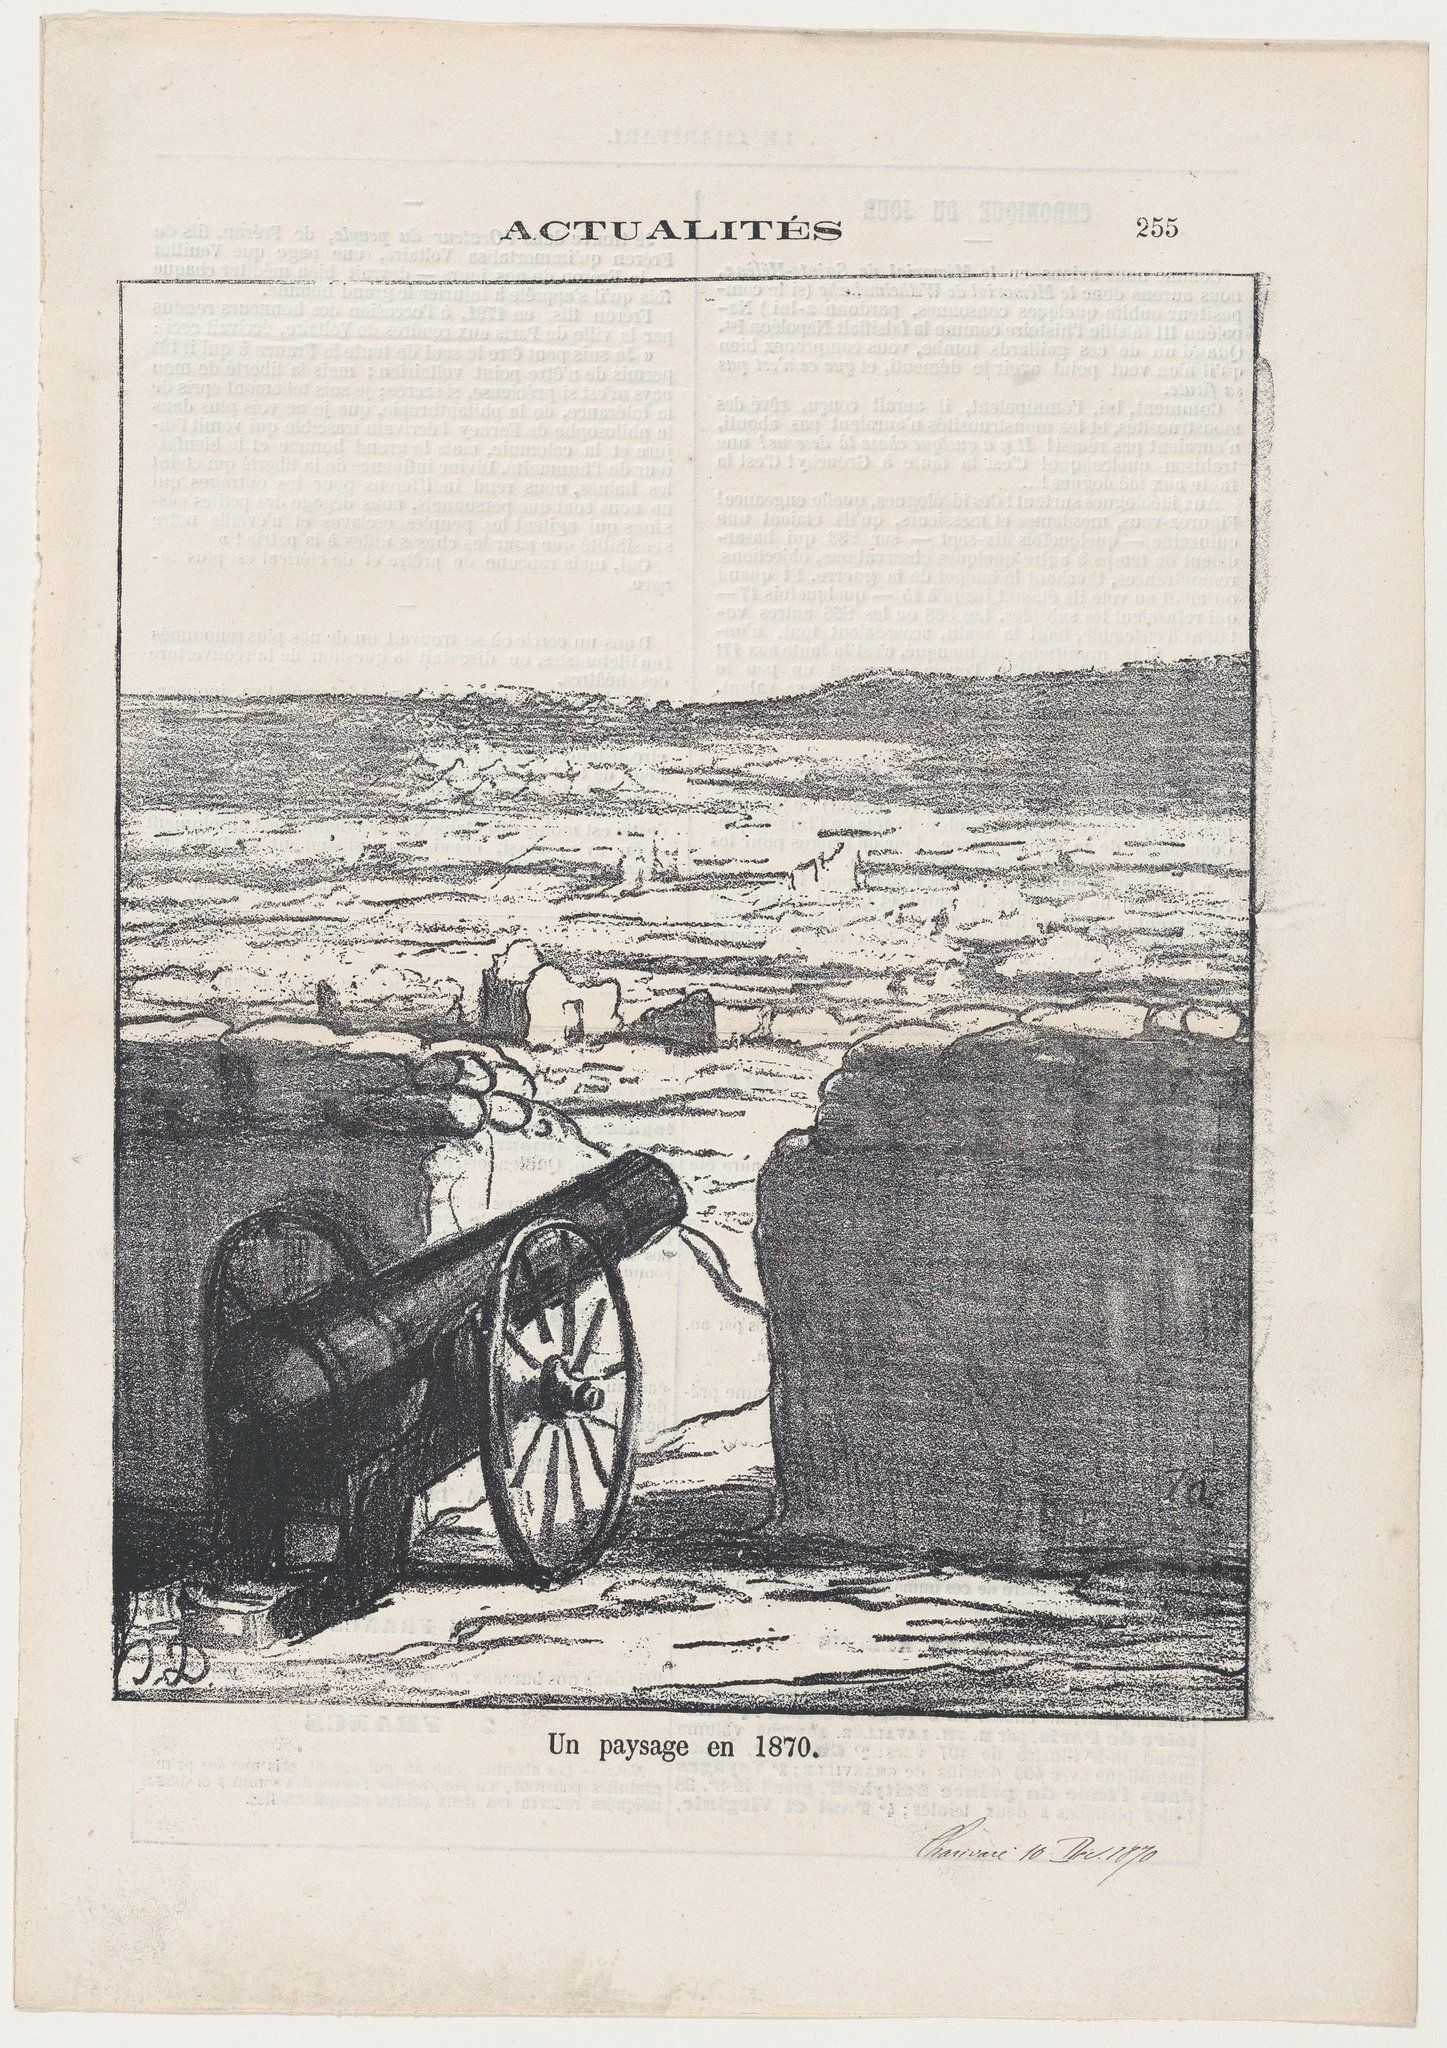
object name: print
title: An 1870 landscape, from 'News of the day,' published in Le Charivari, December 10, 1870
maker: honoré daumier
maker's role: artist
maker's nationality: french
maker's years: 1808-1879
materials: paper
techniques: lithograph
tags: cannons,landscapes